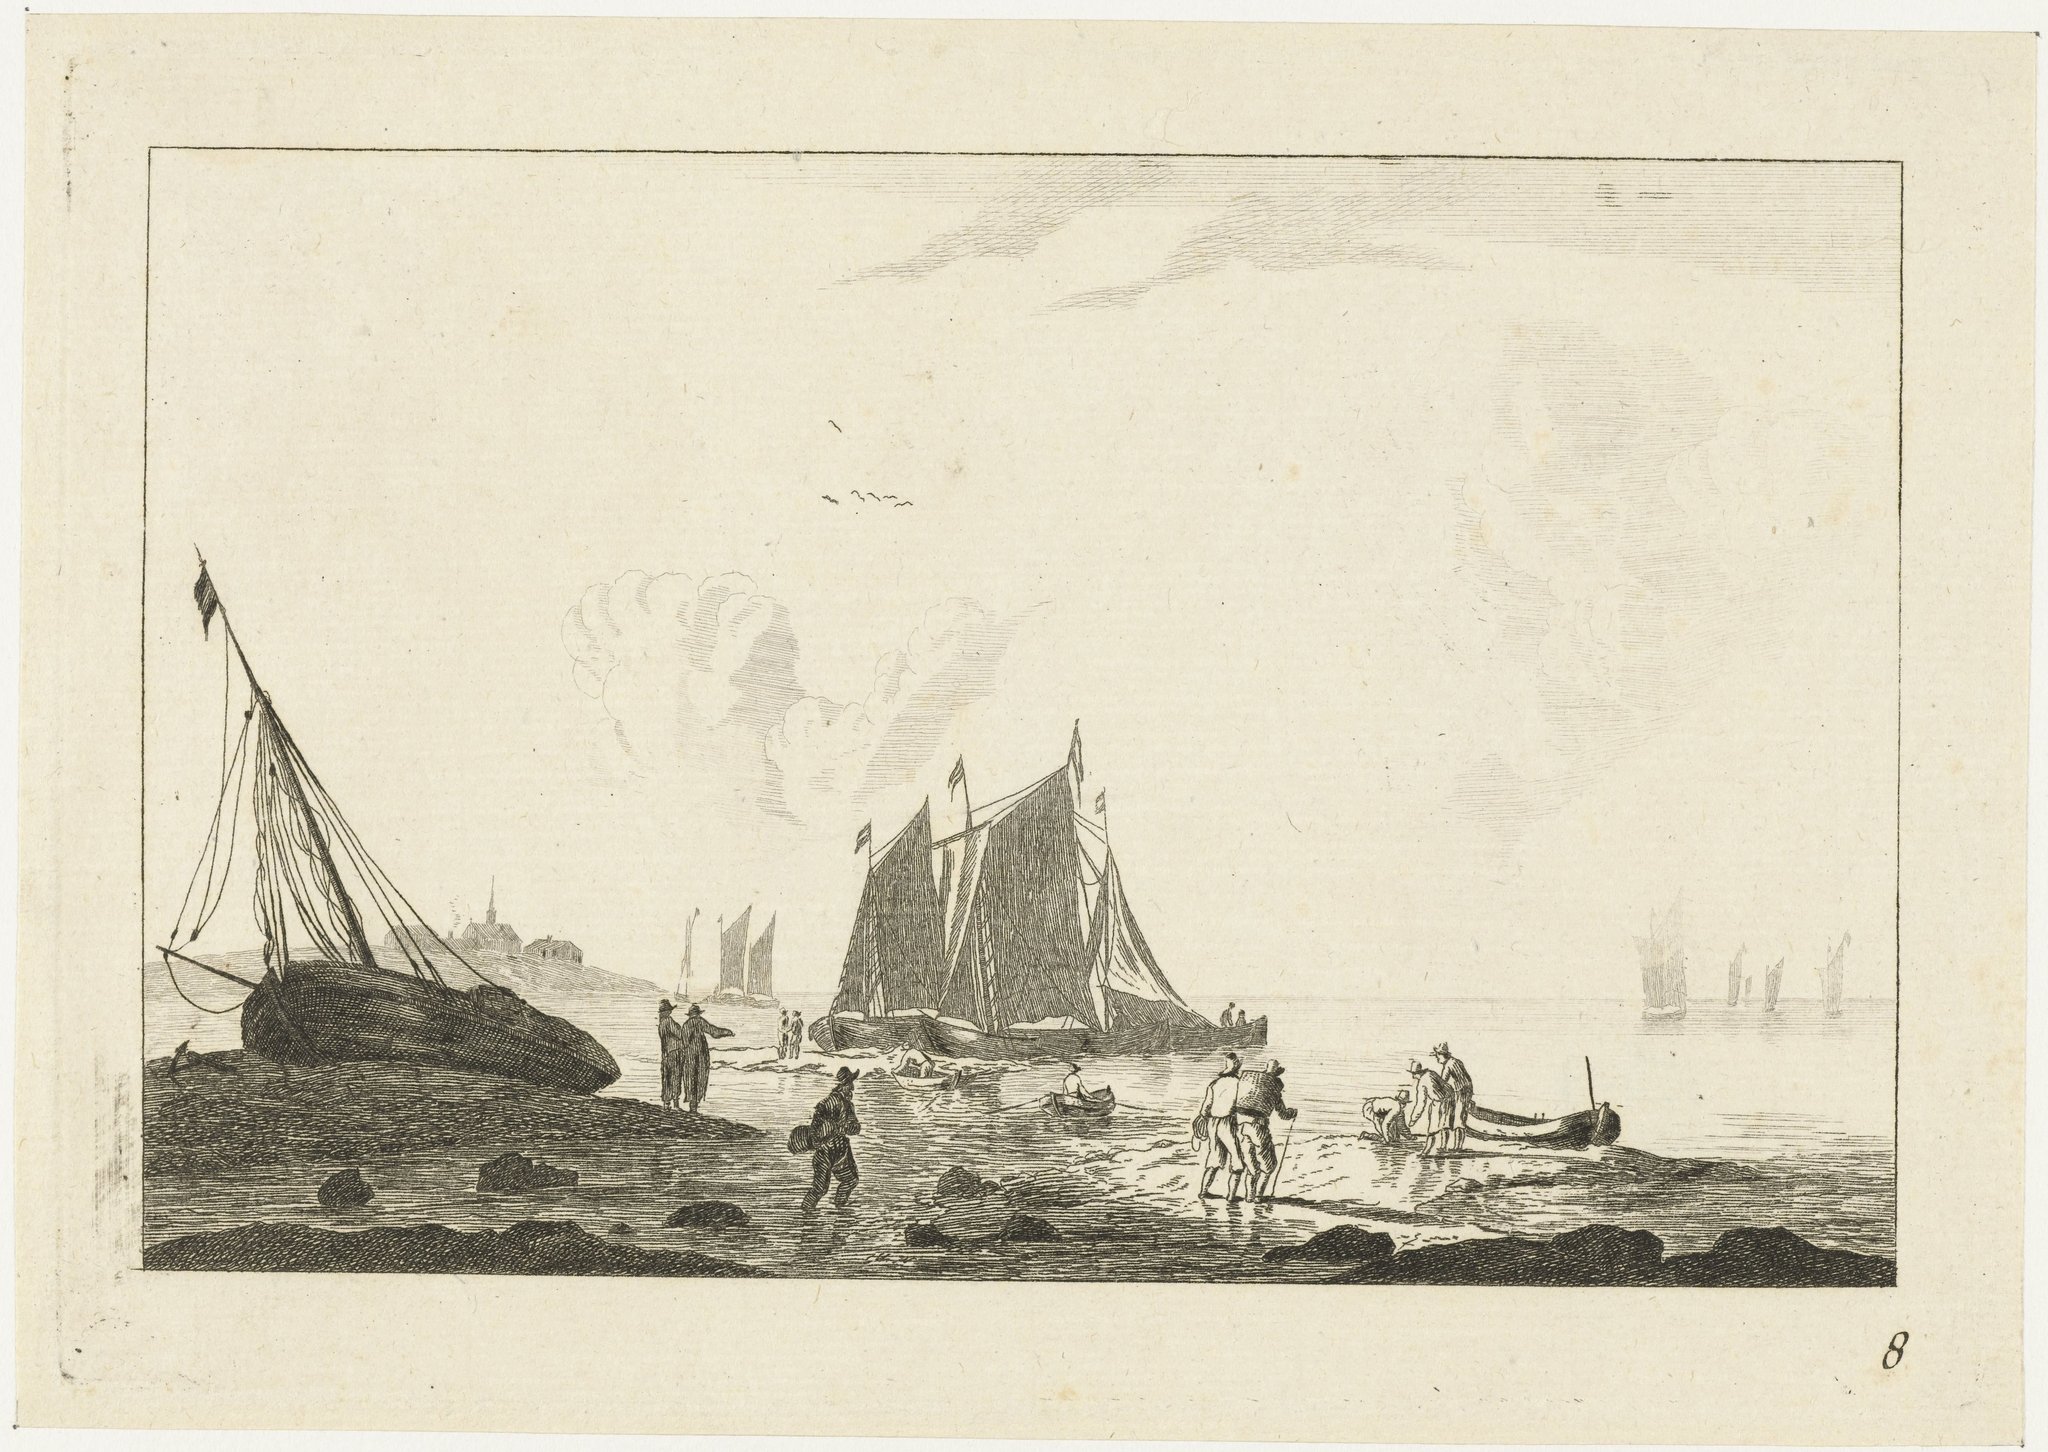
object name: print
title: Huit différentes Marines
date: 1700-1799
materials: paper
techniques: etching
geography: paris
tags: sailing-ship, sailing-boat, beach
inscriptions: collector's mark: Lugt 2228a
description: Mensen lopend op het strand en door het ondiepe water. Een zeilschip op het zand getrokken, een aantal boten liggend in het ondiepe water en een aantal varend op het open water. Op een hoger gelegen stuk land een klein dorp. Kopie in spiegelbeeld.